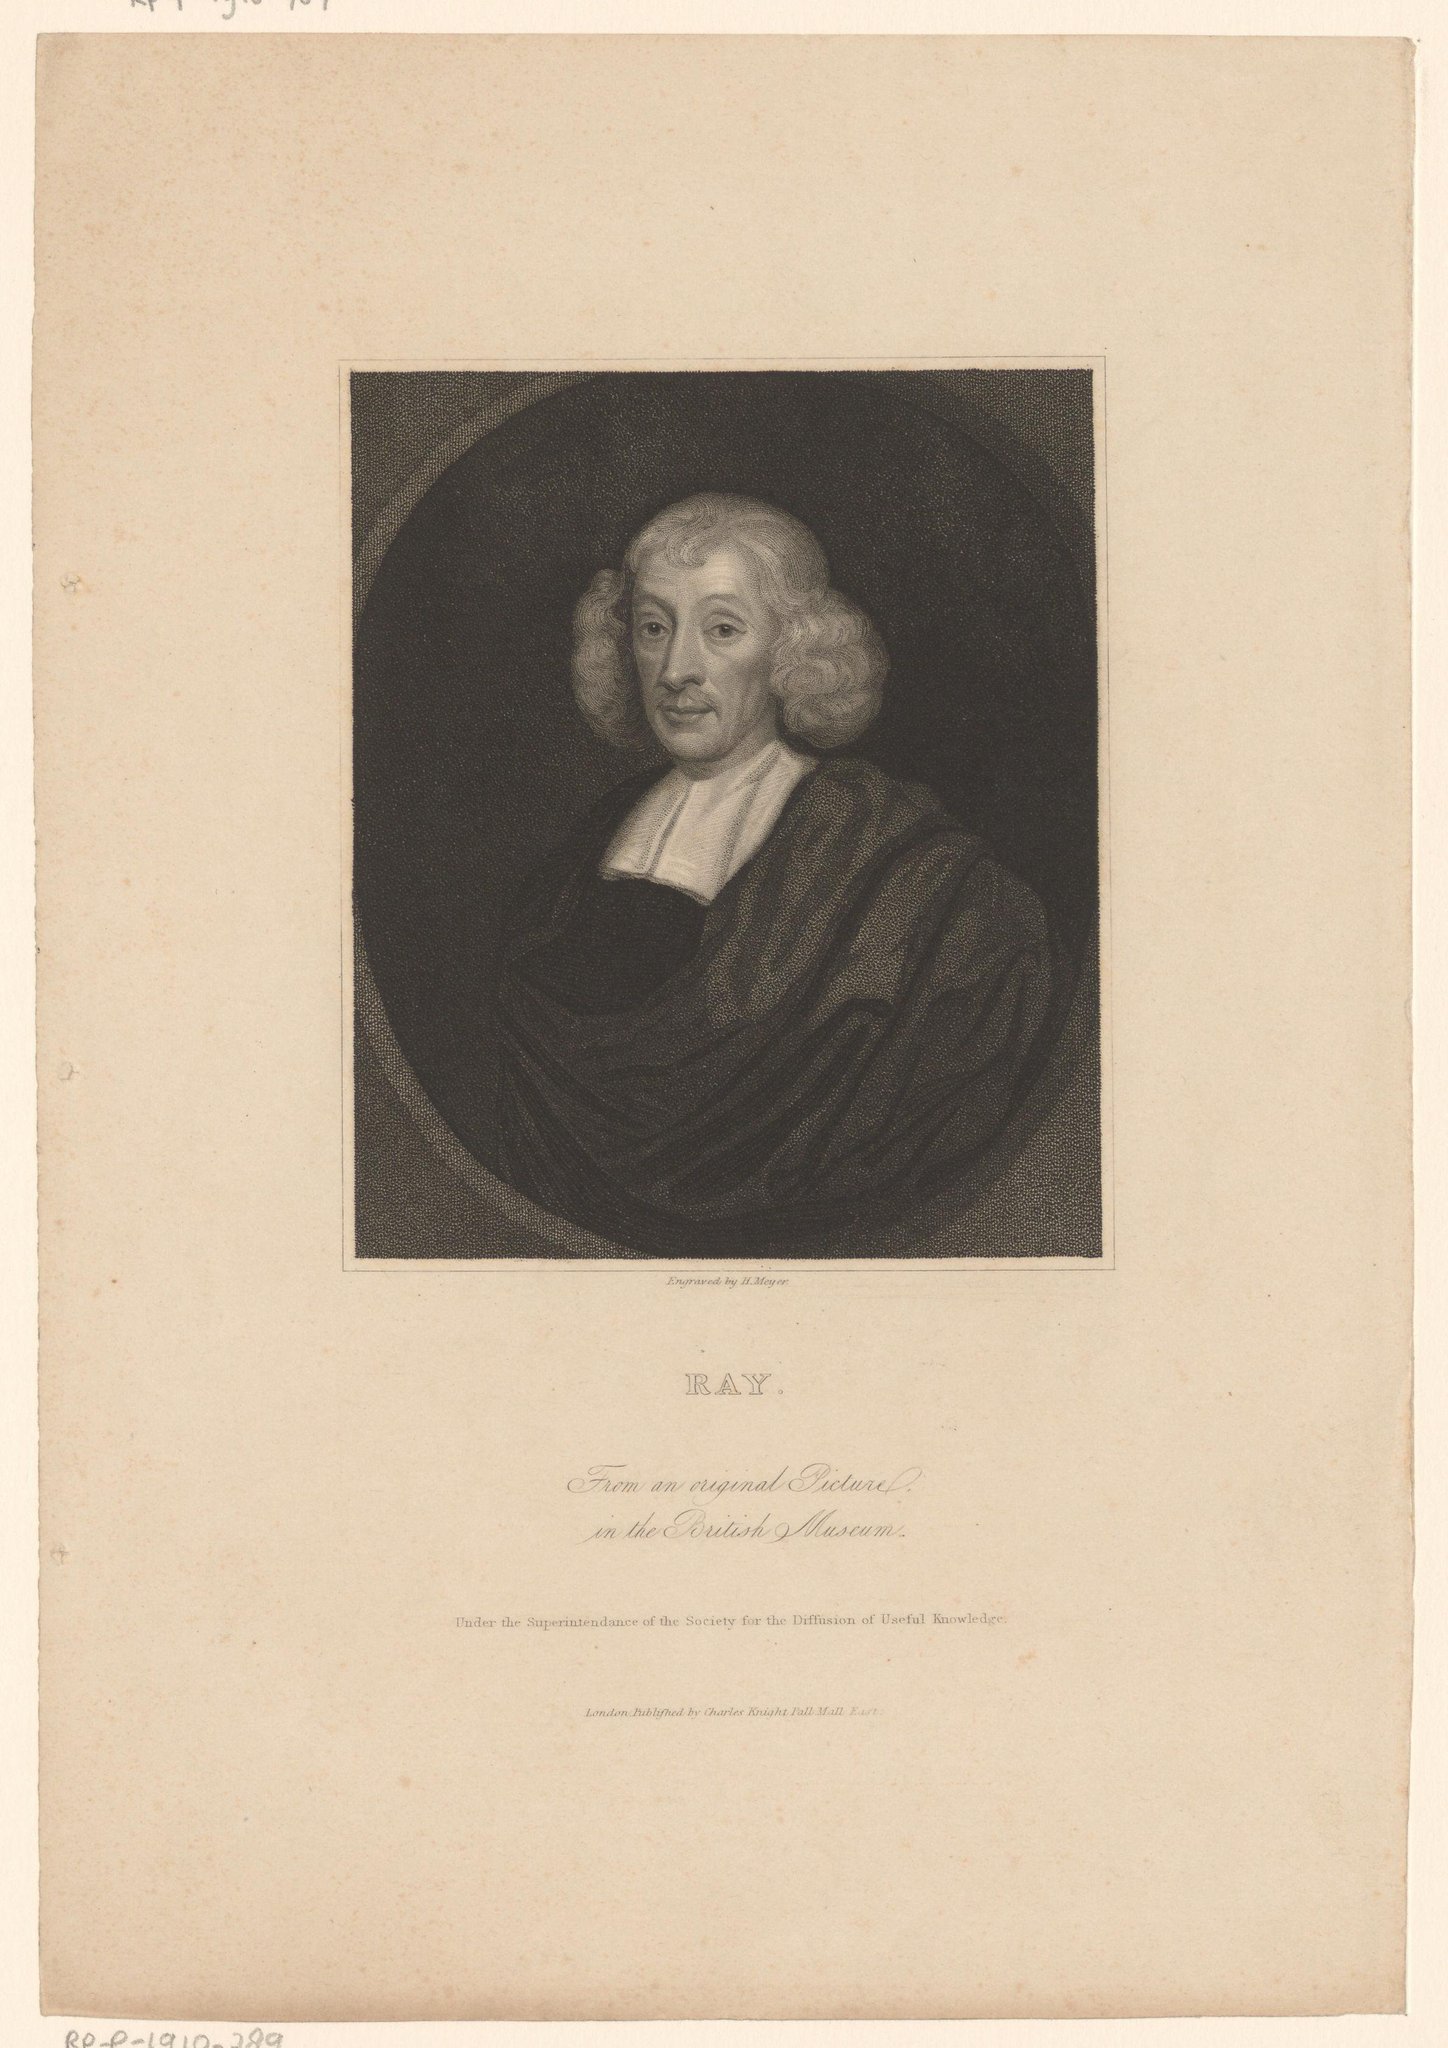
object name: print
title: Ray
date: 1826-1847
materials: paper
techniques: engraving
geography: london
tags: historical persons, scholar, philosopher (+ portrait of scholar, scientist)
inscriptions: collector's mark: Lugt 2228